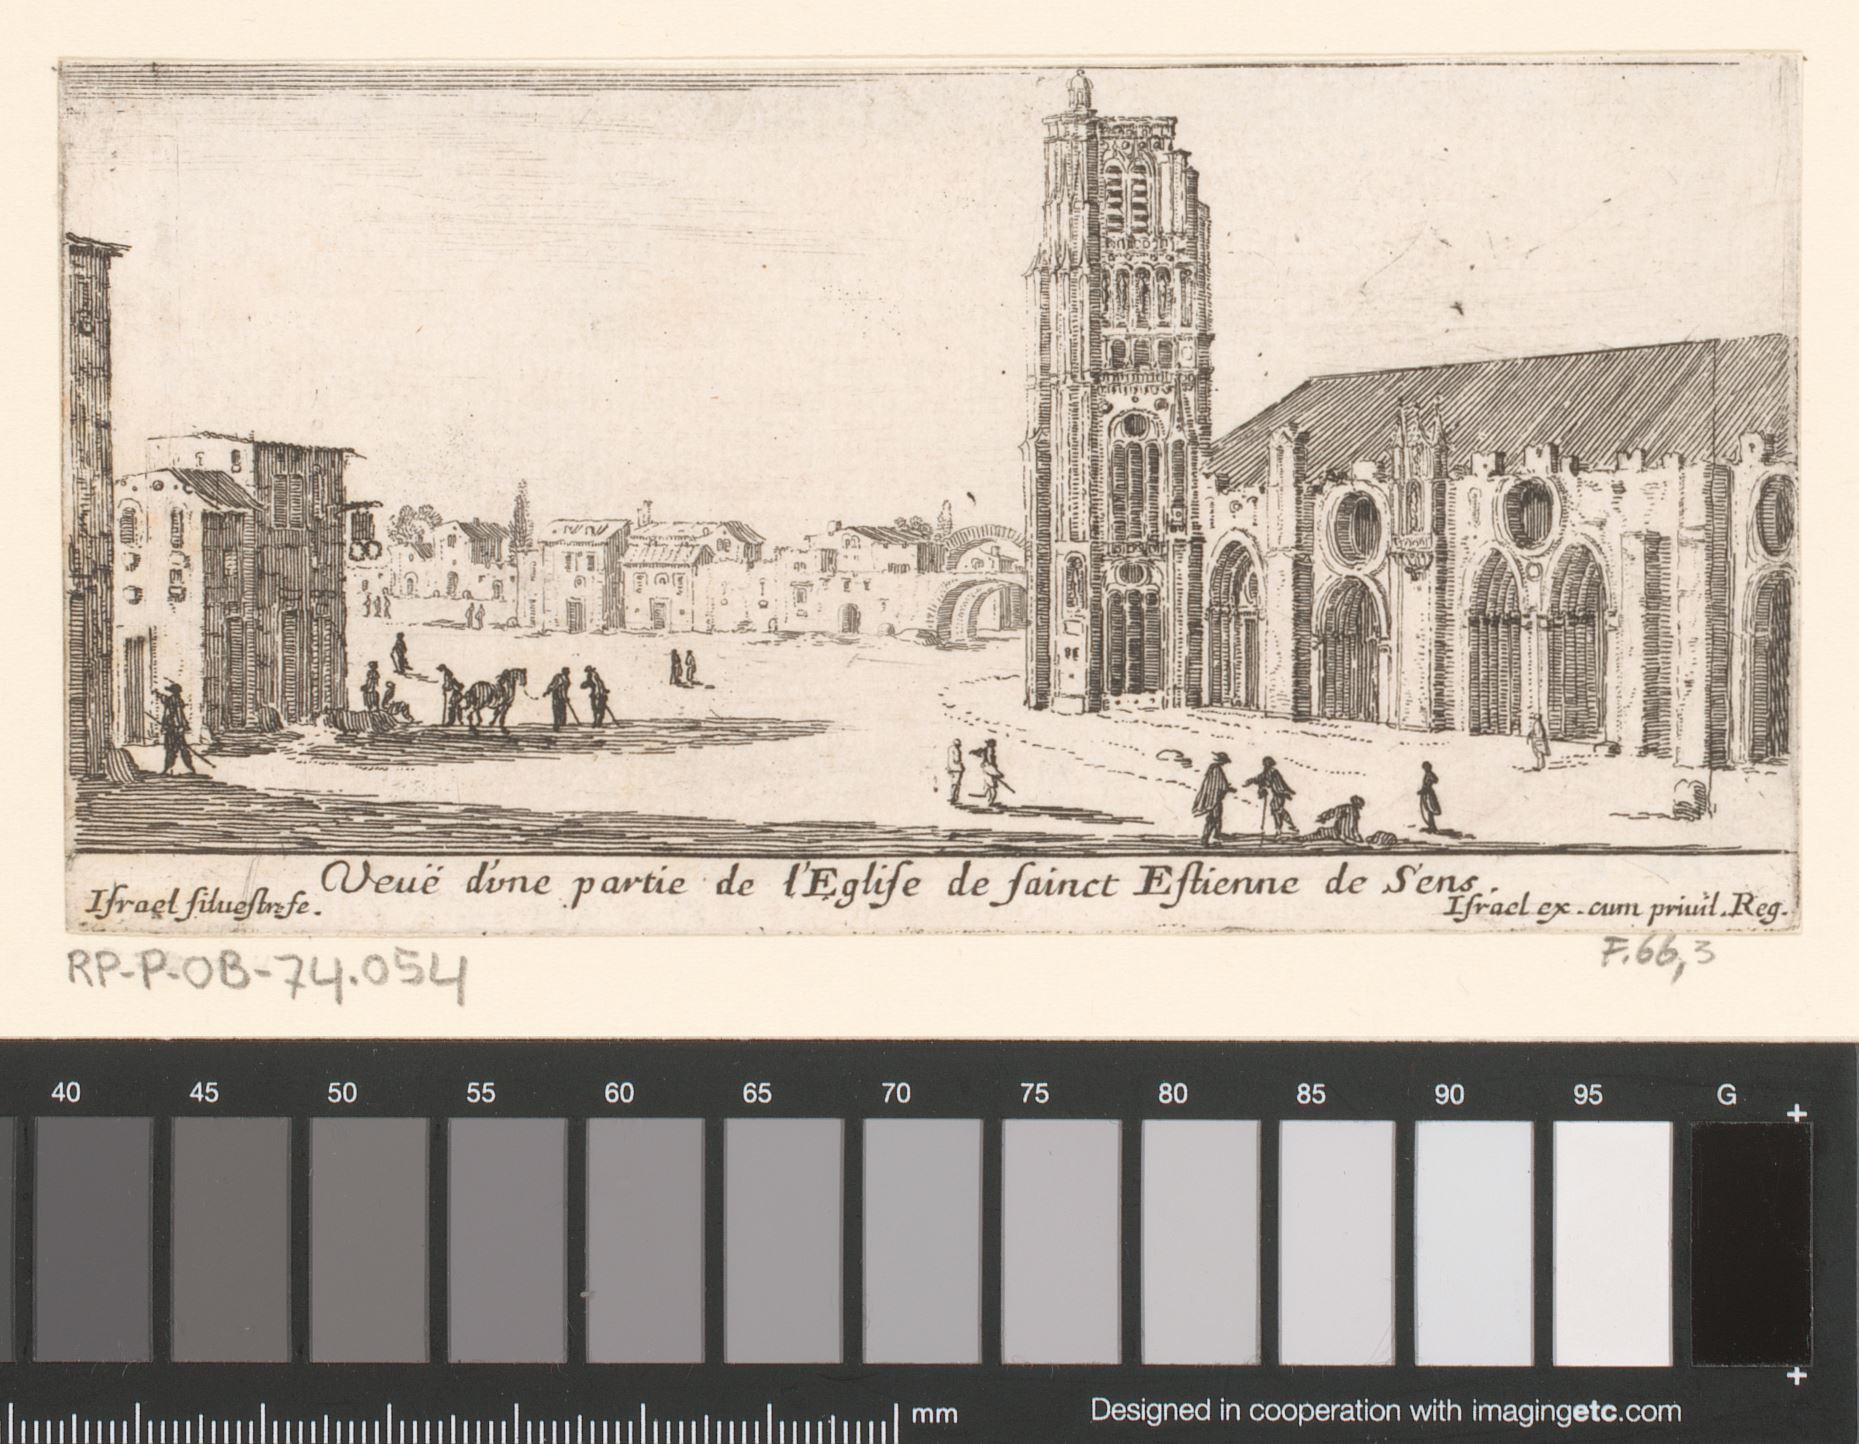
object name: print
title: Veue d'une partie de l'Eglise de sainct Estienne de Sens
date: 1631-1661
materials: paper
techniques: engraving, etching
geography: france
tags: landscape with tower or castle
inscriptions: collector's mark: Lugt 240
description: Prent maakt deel uit van een ongenummerde serie van negen prenten.